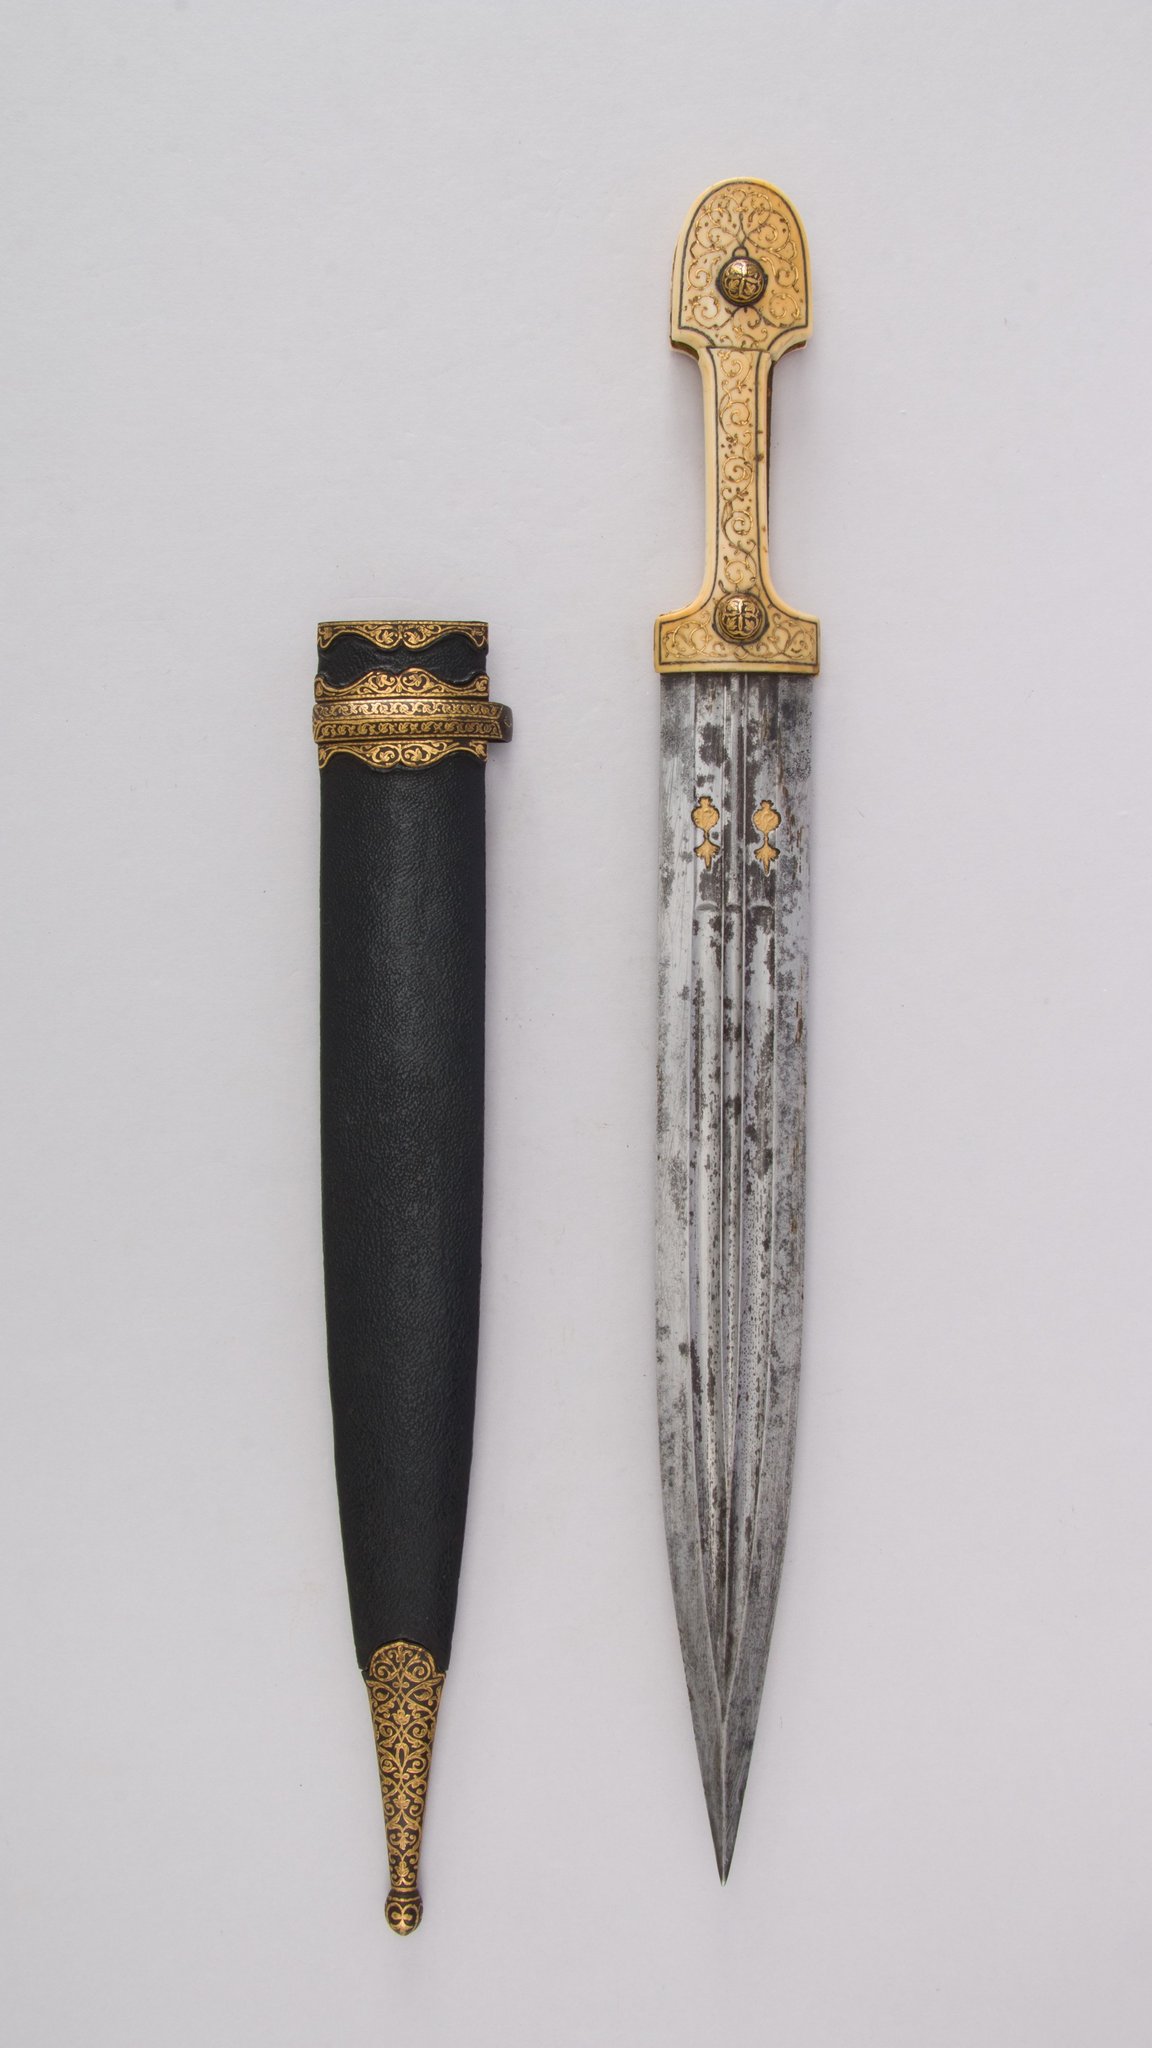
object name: dagger with sheath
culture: caucasian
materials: gold, ivory, leather, silver, steel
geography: georgia